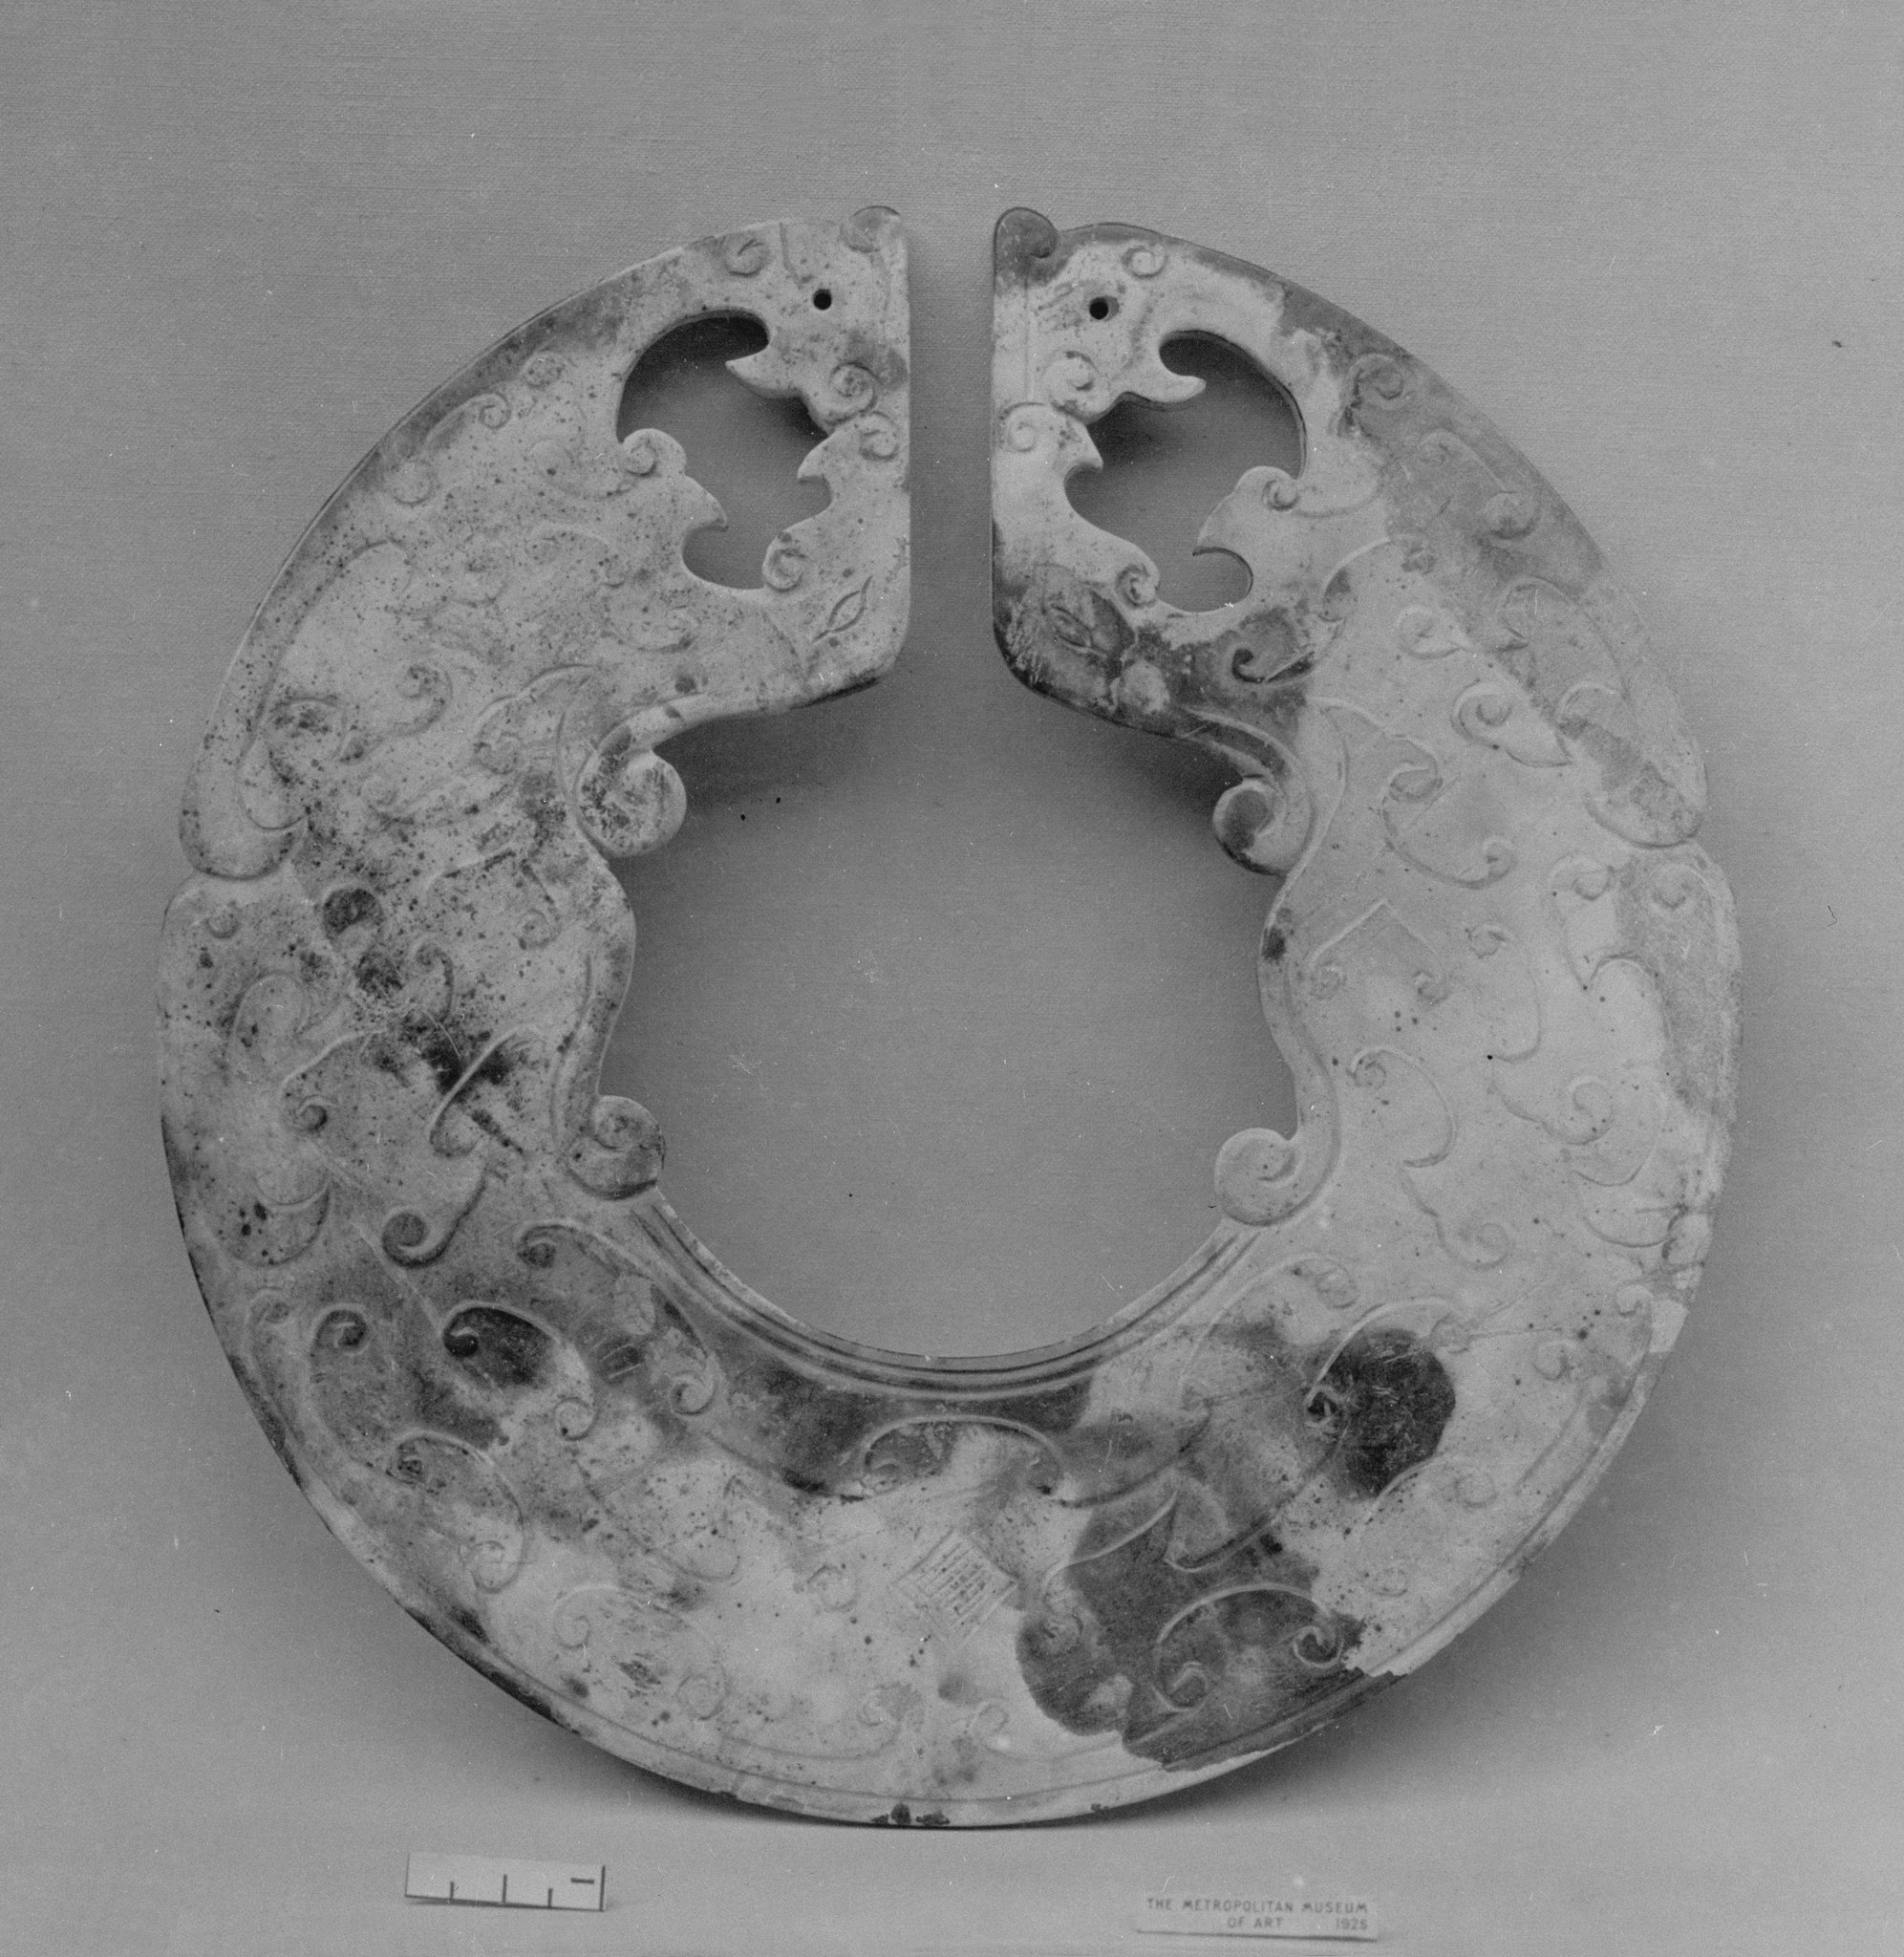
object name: incomplete ring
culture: chinese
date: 206 BCE-220 CE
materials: jade